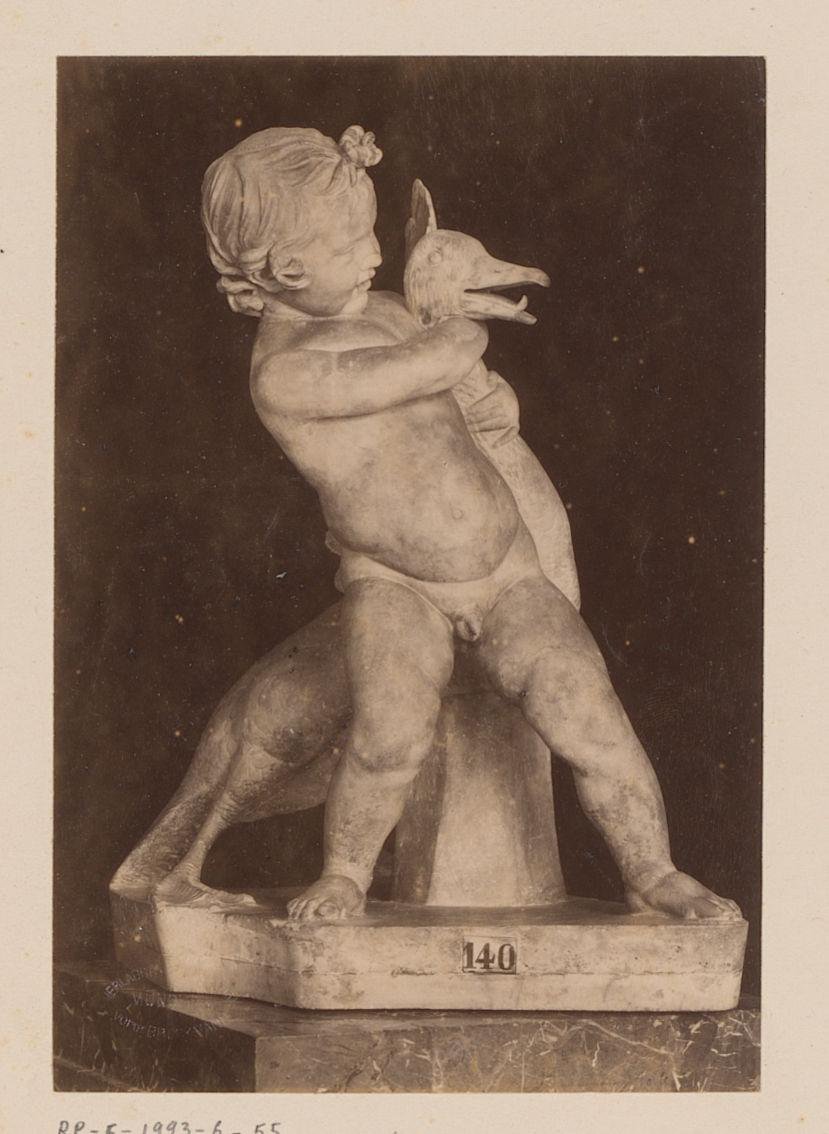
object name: photograph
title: Sculptuur van een jongen met gans, Glyptothek München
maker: Anonymous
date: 1863-1890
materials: paper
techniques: albumen print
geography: munich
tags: water-birds: goose, piece of sculpture, reproduction of a piece of sculpture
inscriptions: inscription: ‘Verlagsanstalt K.u.W./ München/ vorm. Bruckmann’